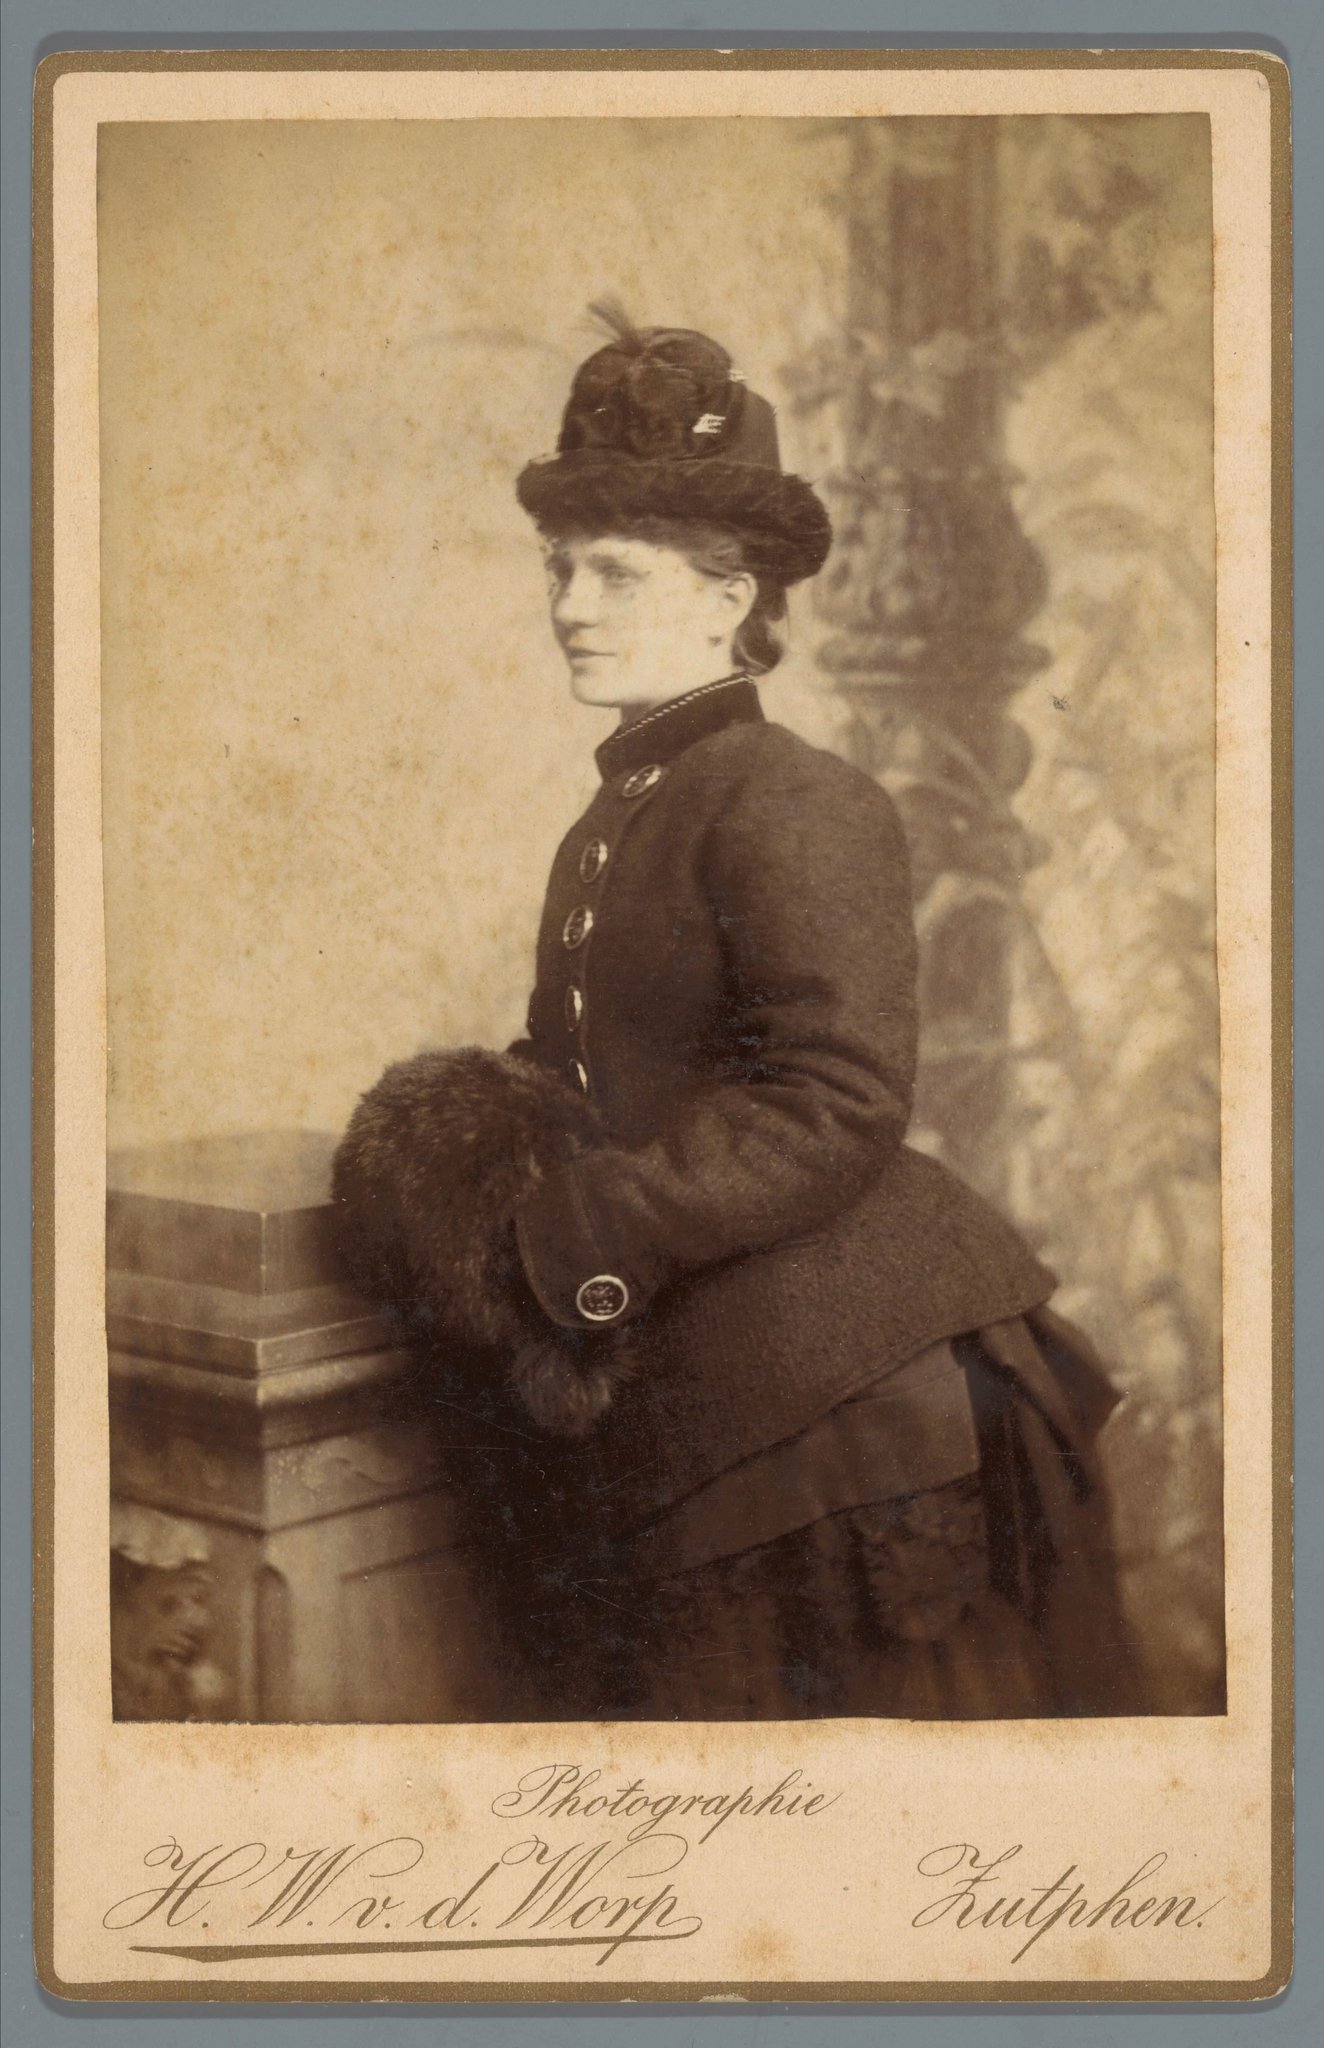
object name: cabinet photograph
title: Portret van een onbekende vrouw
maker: herman van der worp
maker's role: fotograaf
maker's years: 1849-1941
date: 1880-1900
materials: cardboard, photographic support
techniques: albumen print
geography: zutphen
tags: adult woman